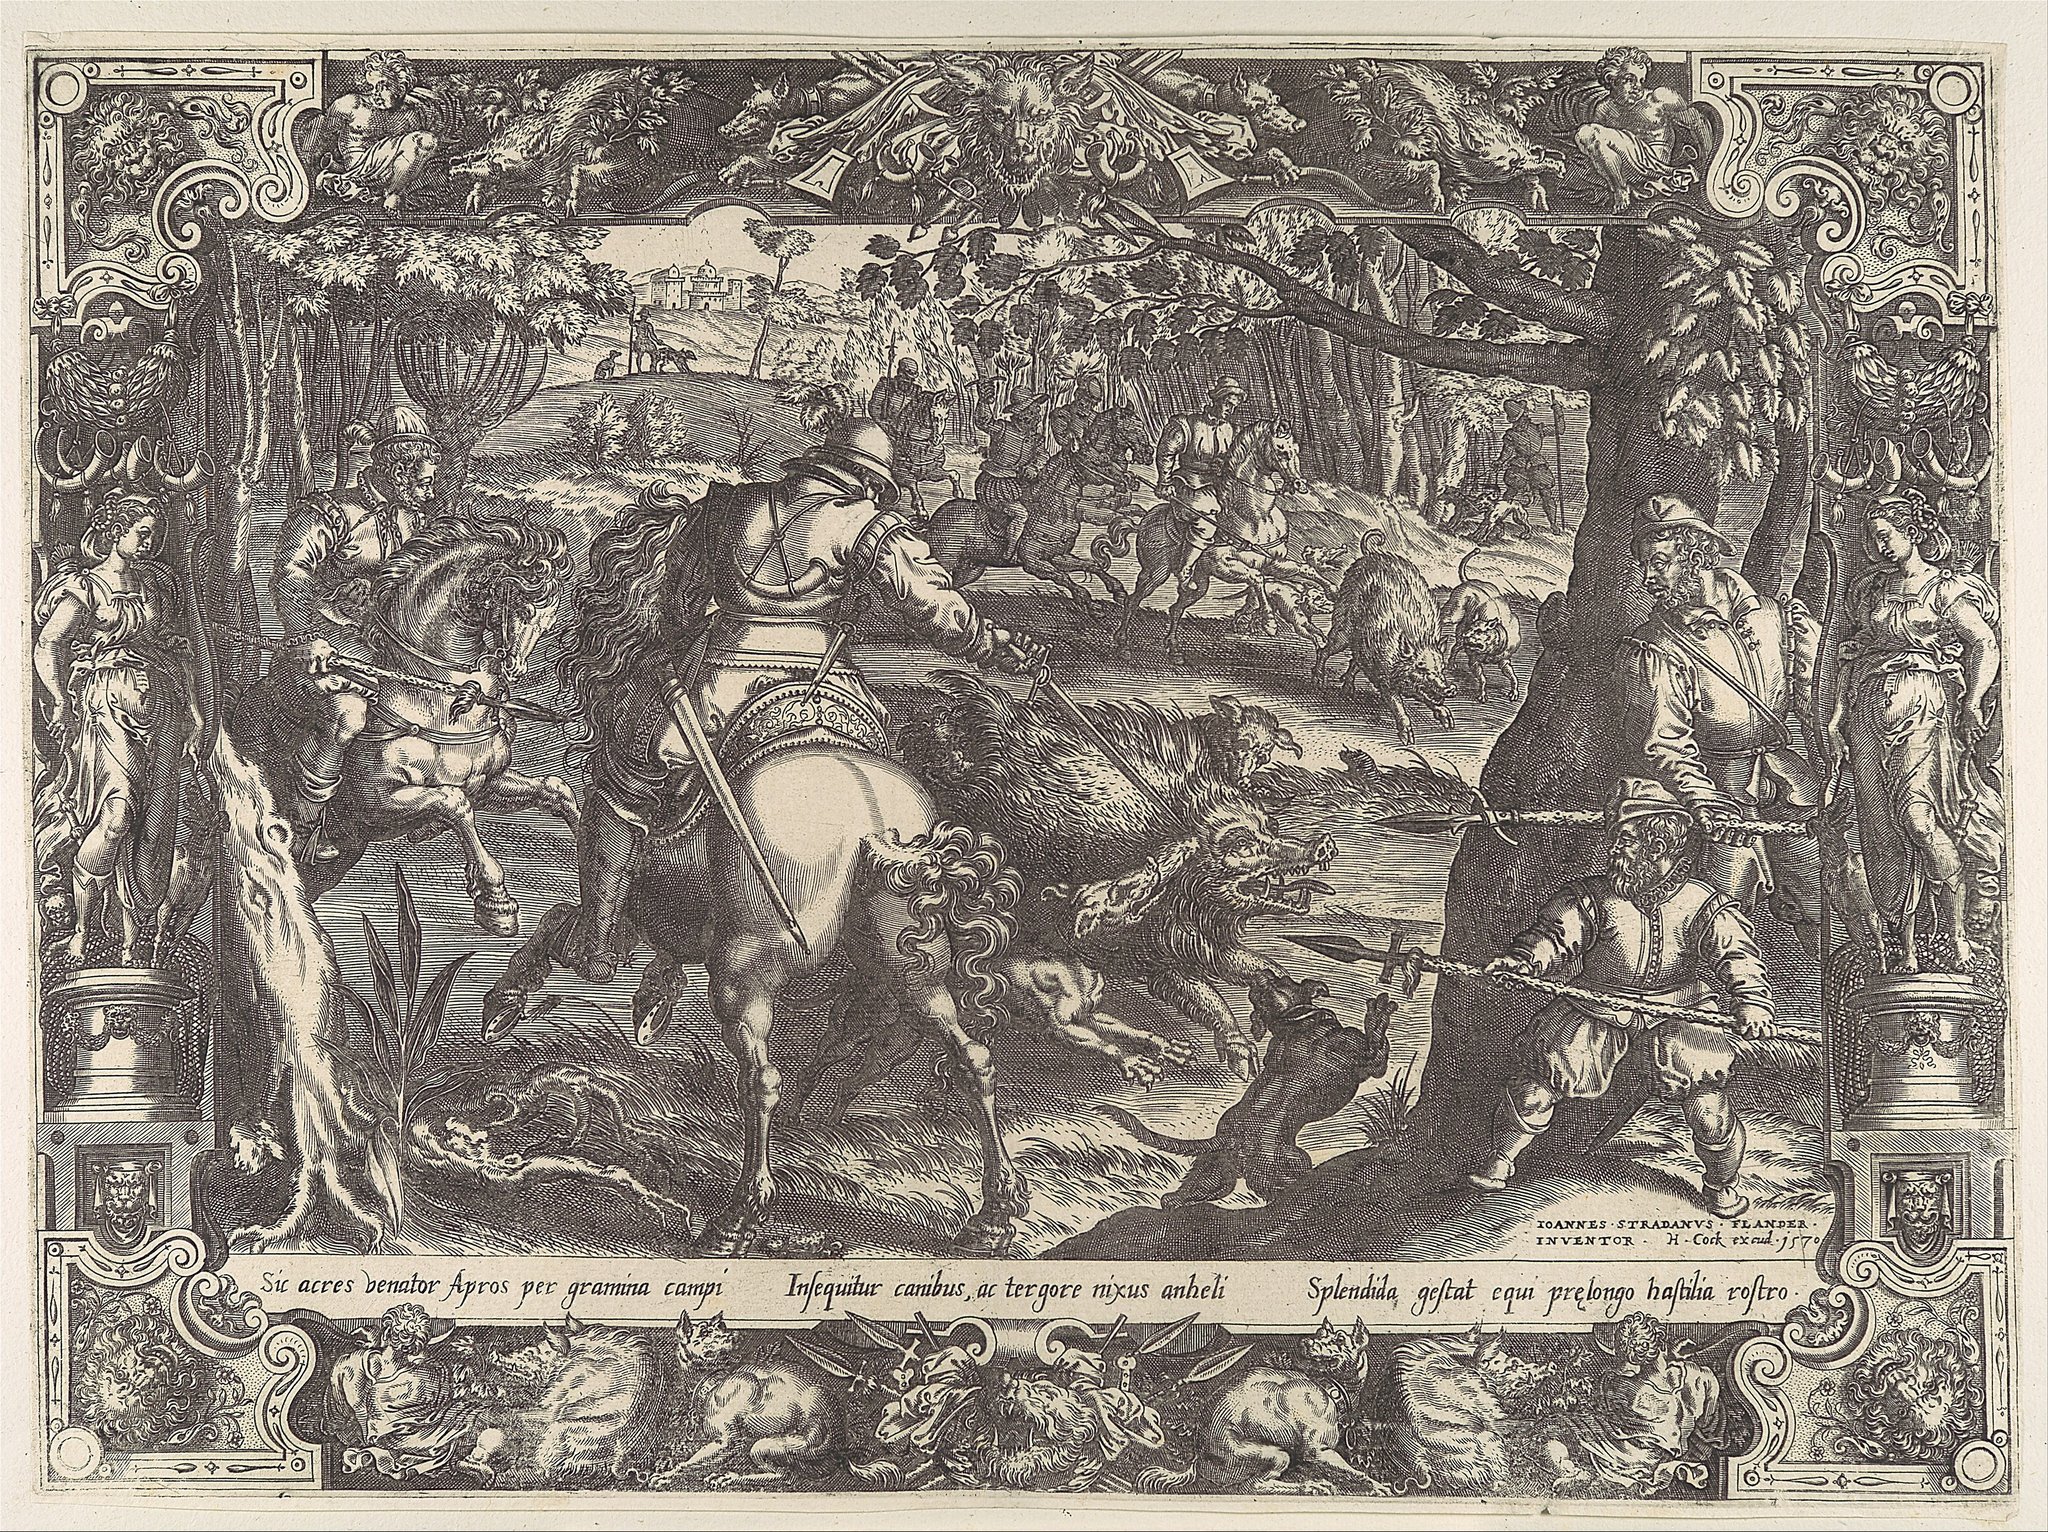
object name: print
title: Wild Boar Hunt with Spears, from "Hunting Scenes in Ornamental Frames"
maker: jan van der straet, called stradanus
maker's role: artist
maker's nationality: netherlandish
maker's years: 1523-1605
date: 1570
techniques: engraving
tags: hunting,boars,dogs,horses